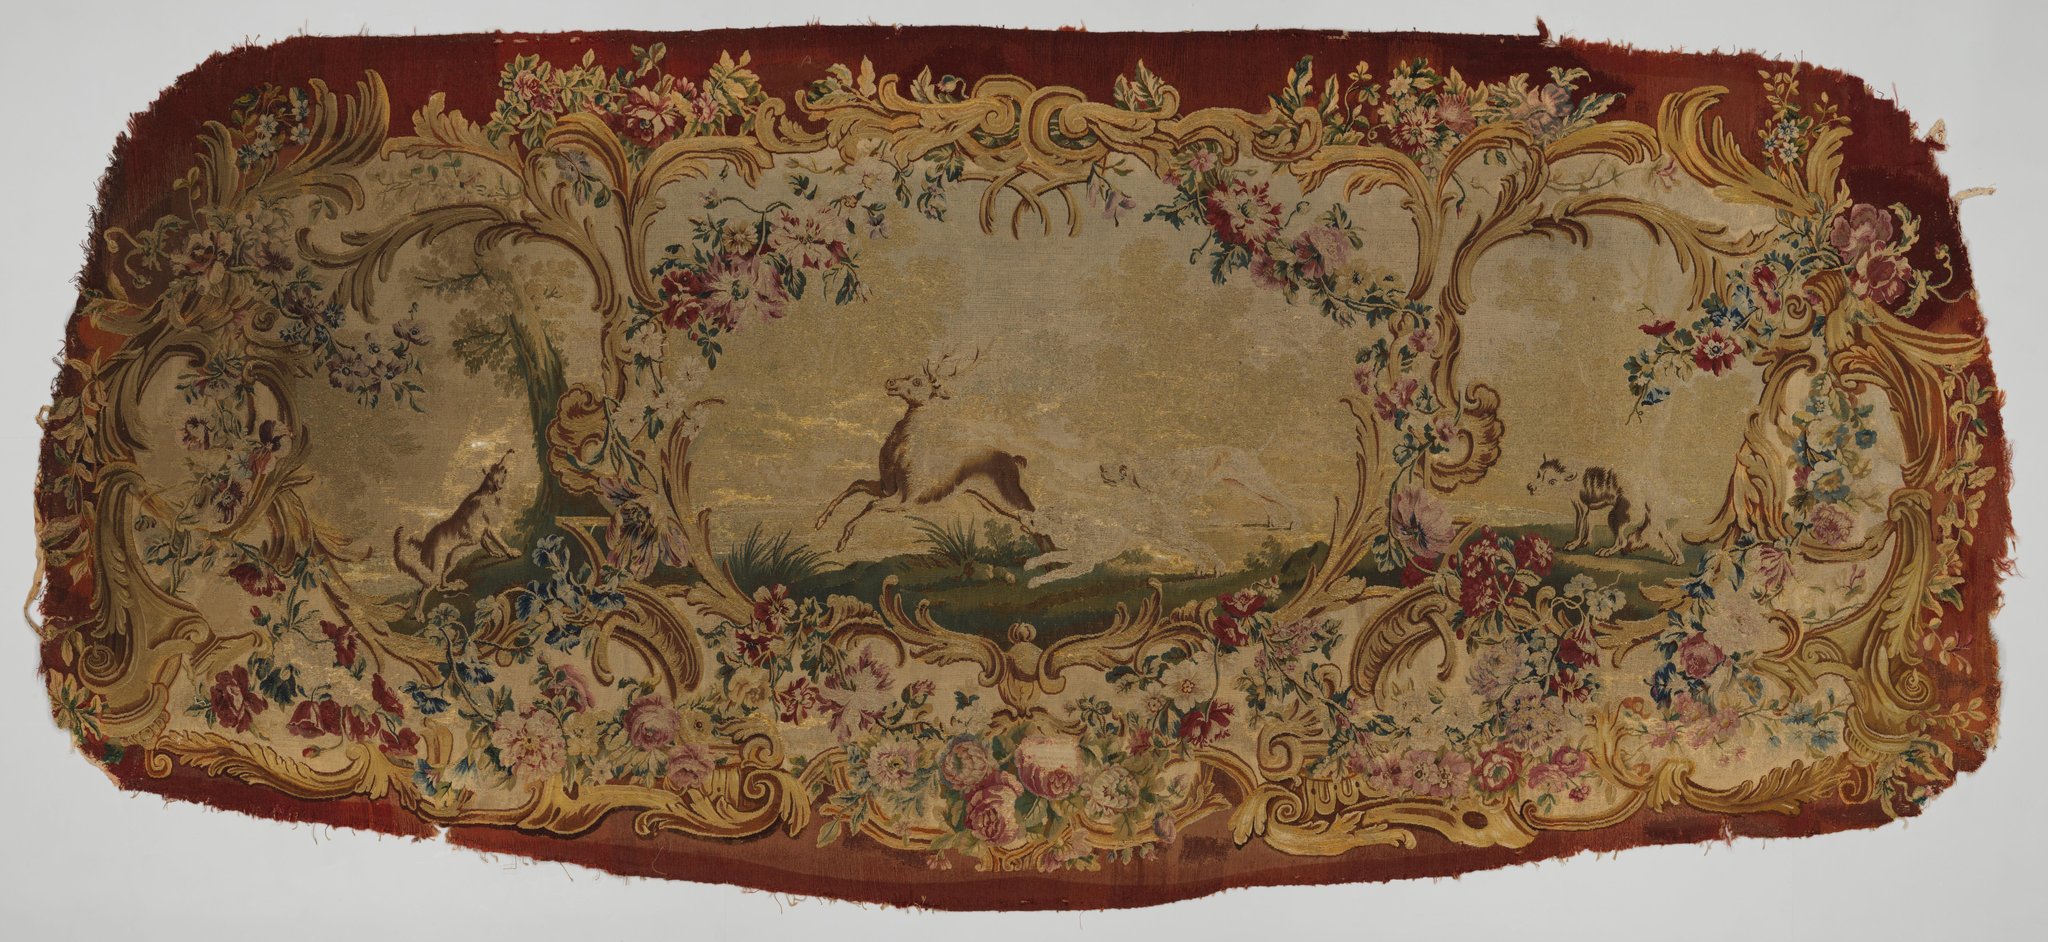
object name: upholstered seat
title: Canapézitting met een vos die naar een boom kijkt, twee honden die een hert najagen en een wegsluipende vos, omgeven door rocailles en bloemguirlandes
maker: jean-baptiste oudry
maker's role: draughtsman, print maker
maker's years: 1686-1755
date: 1750-1760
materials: silk, wool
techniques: tapestry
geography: beauvais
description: Canapé-rug van tapisserie. Op een donkerrode fond staan binnen gele rocailles met bloemslingers afgewisseld drie medaillons met landschap. De middelste en grootste met een hert, door twee honden gejaagd, het linkse met een vos onder een boom, het rechtse met een afdruipende (?) wolf (?). Behoort tot dezelfde serie als BK-1956-52. De rug vertoont veel slijtage.